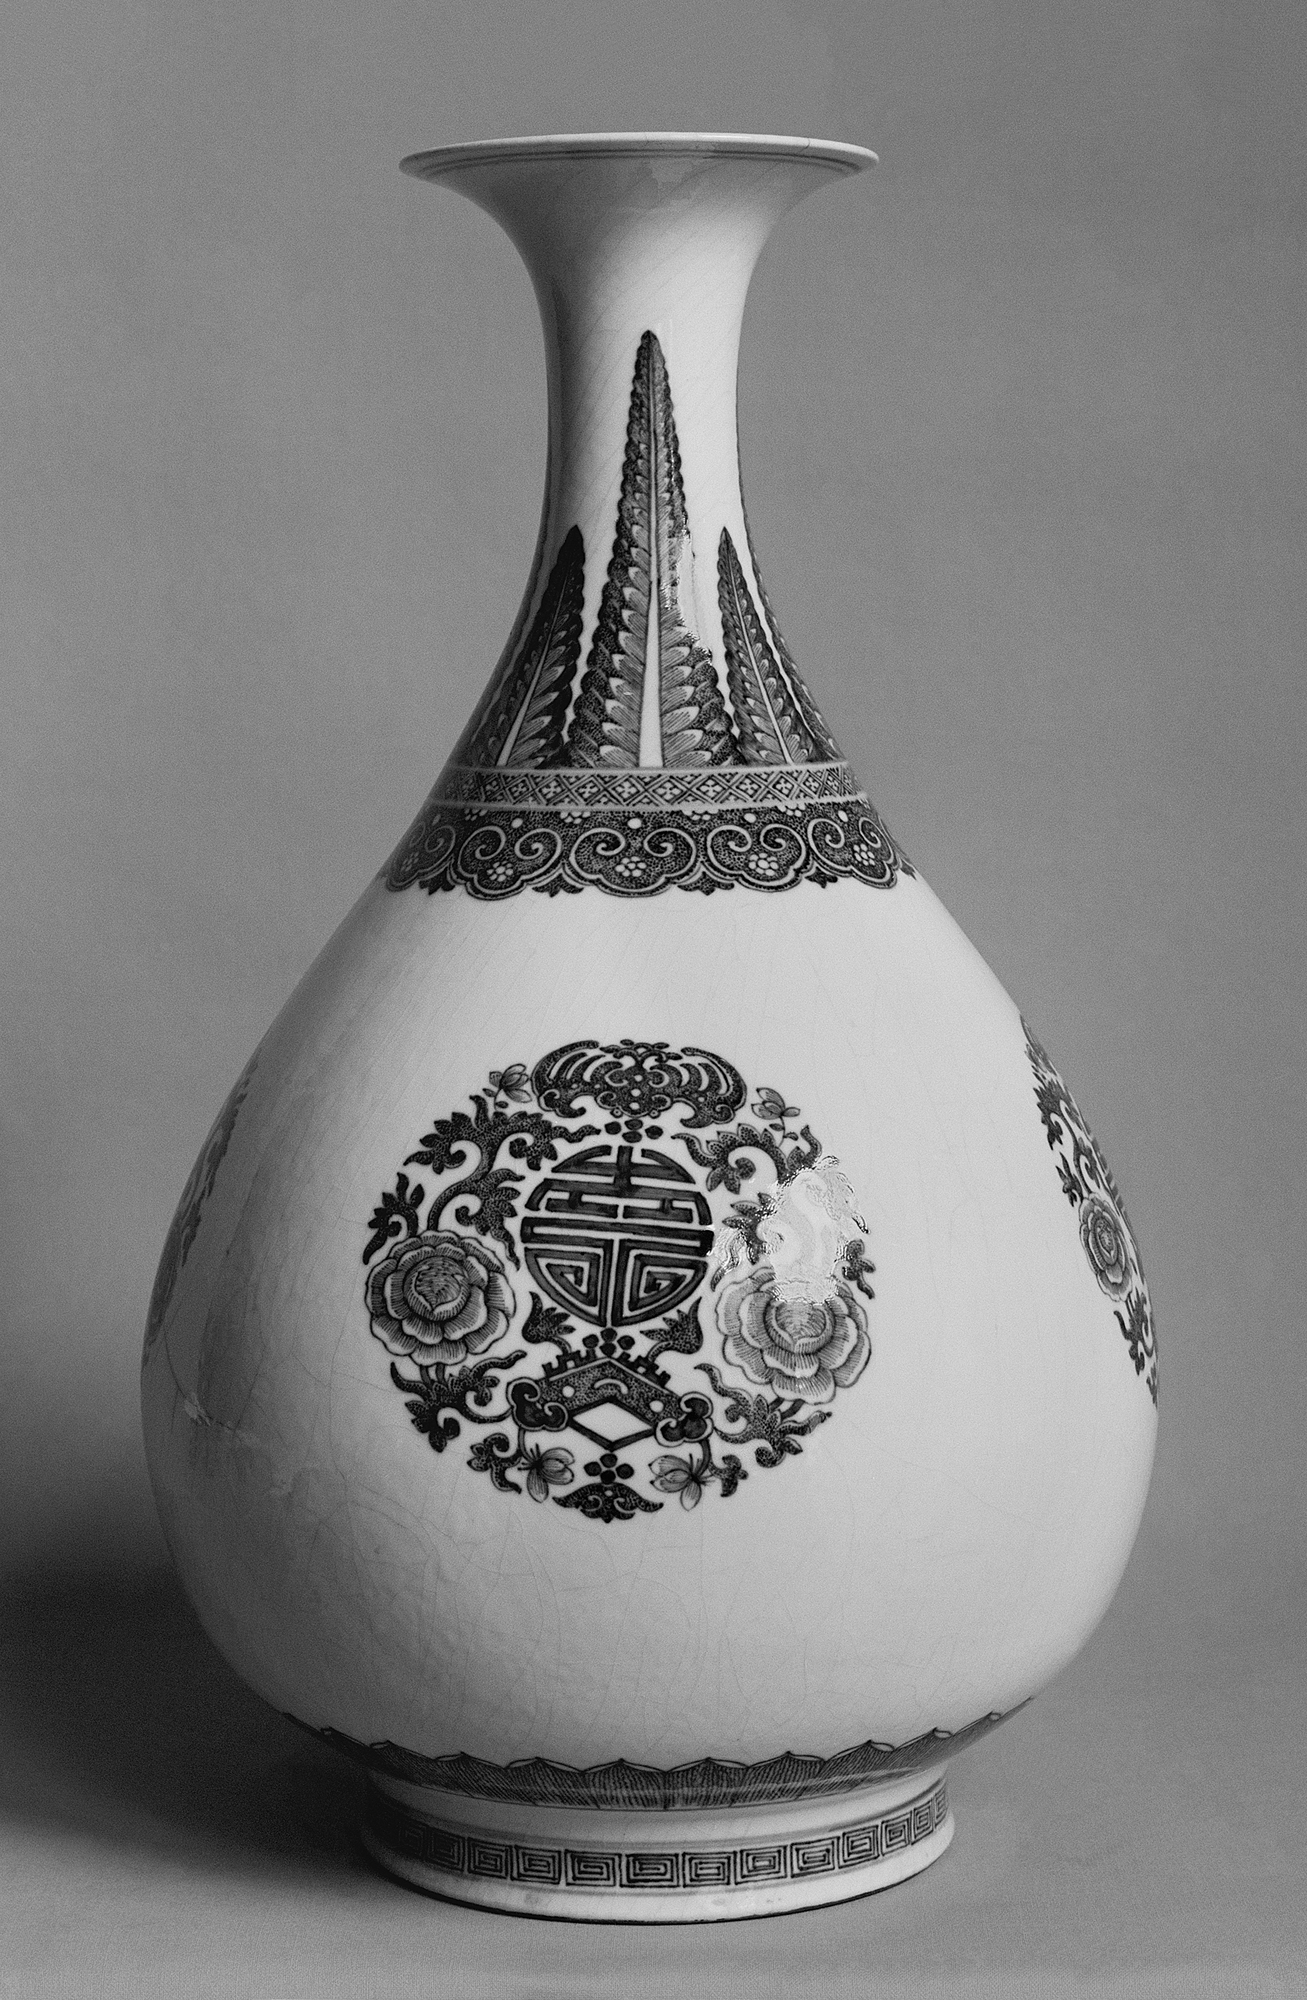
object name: vase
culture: chinese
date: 1701-1800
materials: paste, porcelain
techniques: painting, underglaze